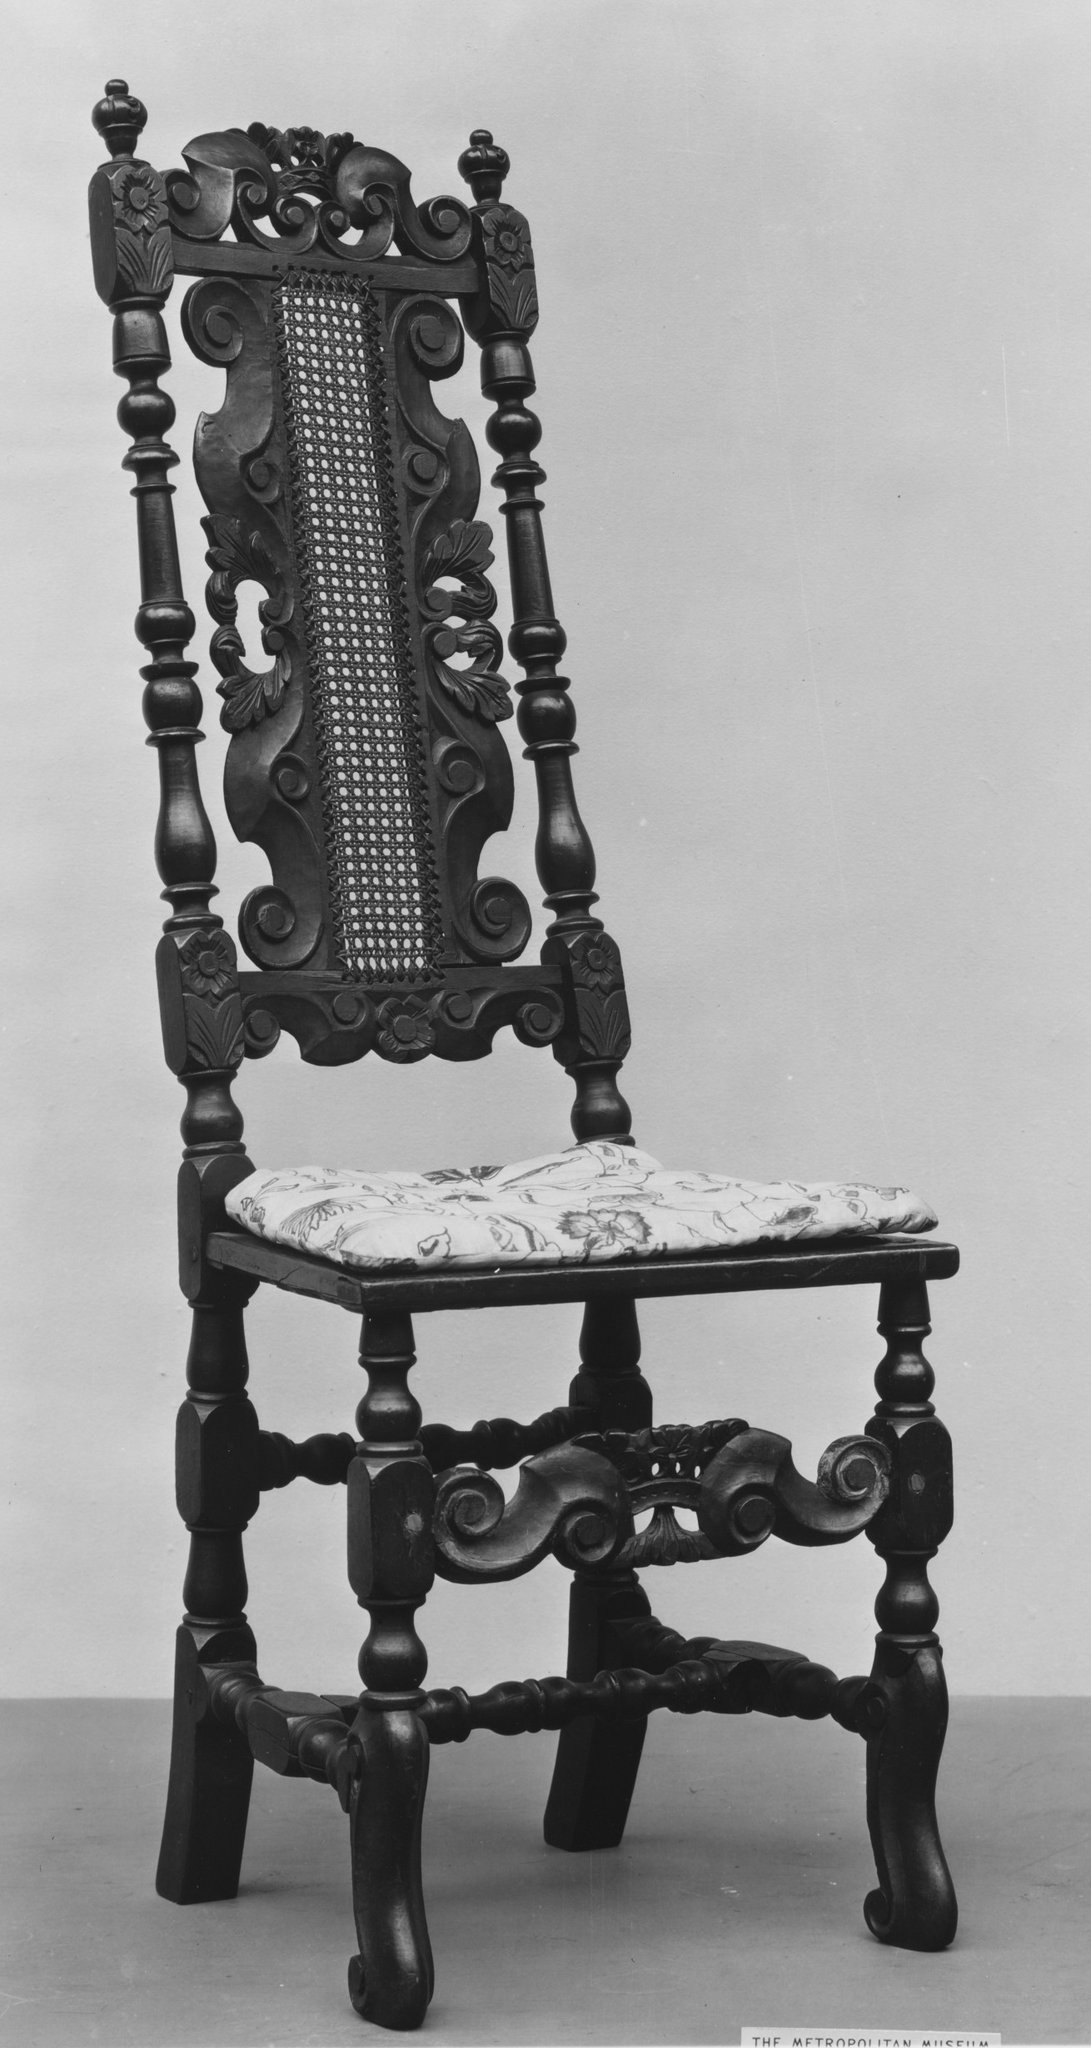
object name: side chair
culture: british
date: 1690-1710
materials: wood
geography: england